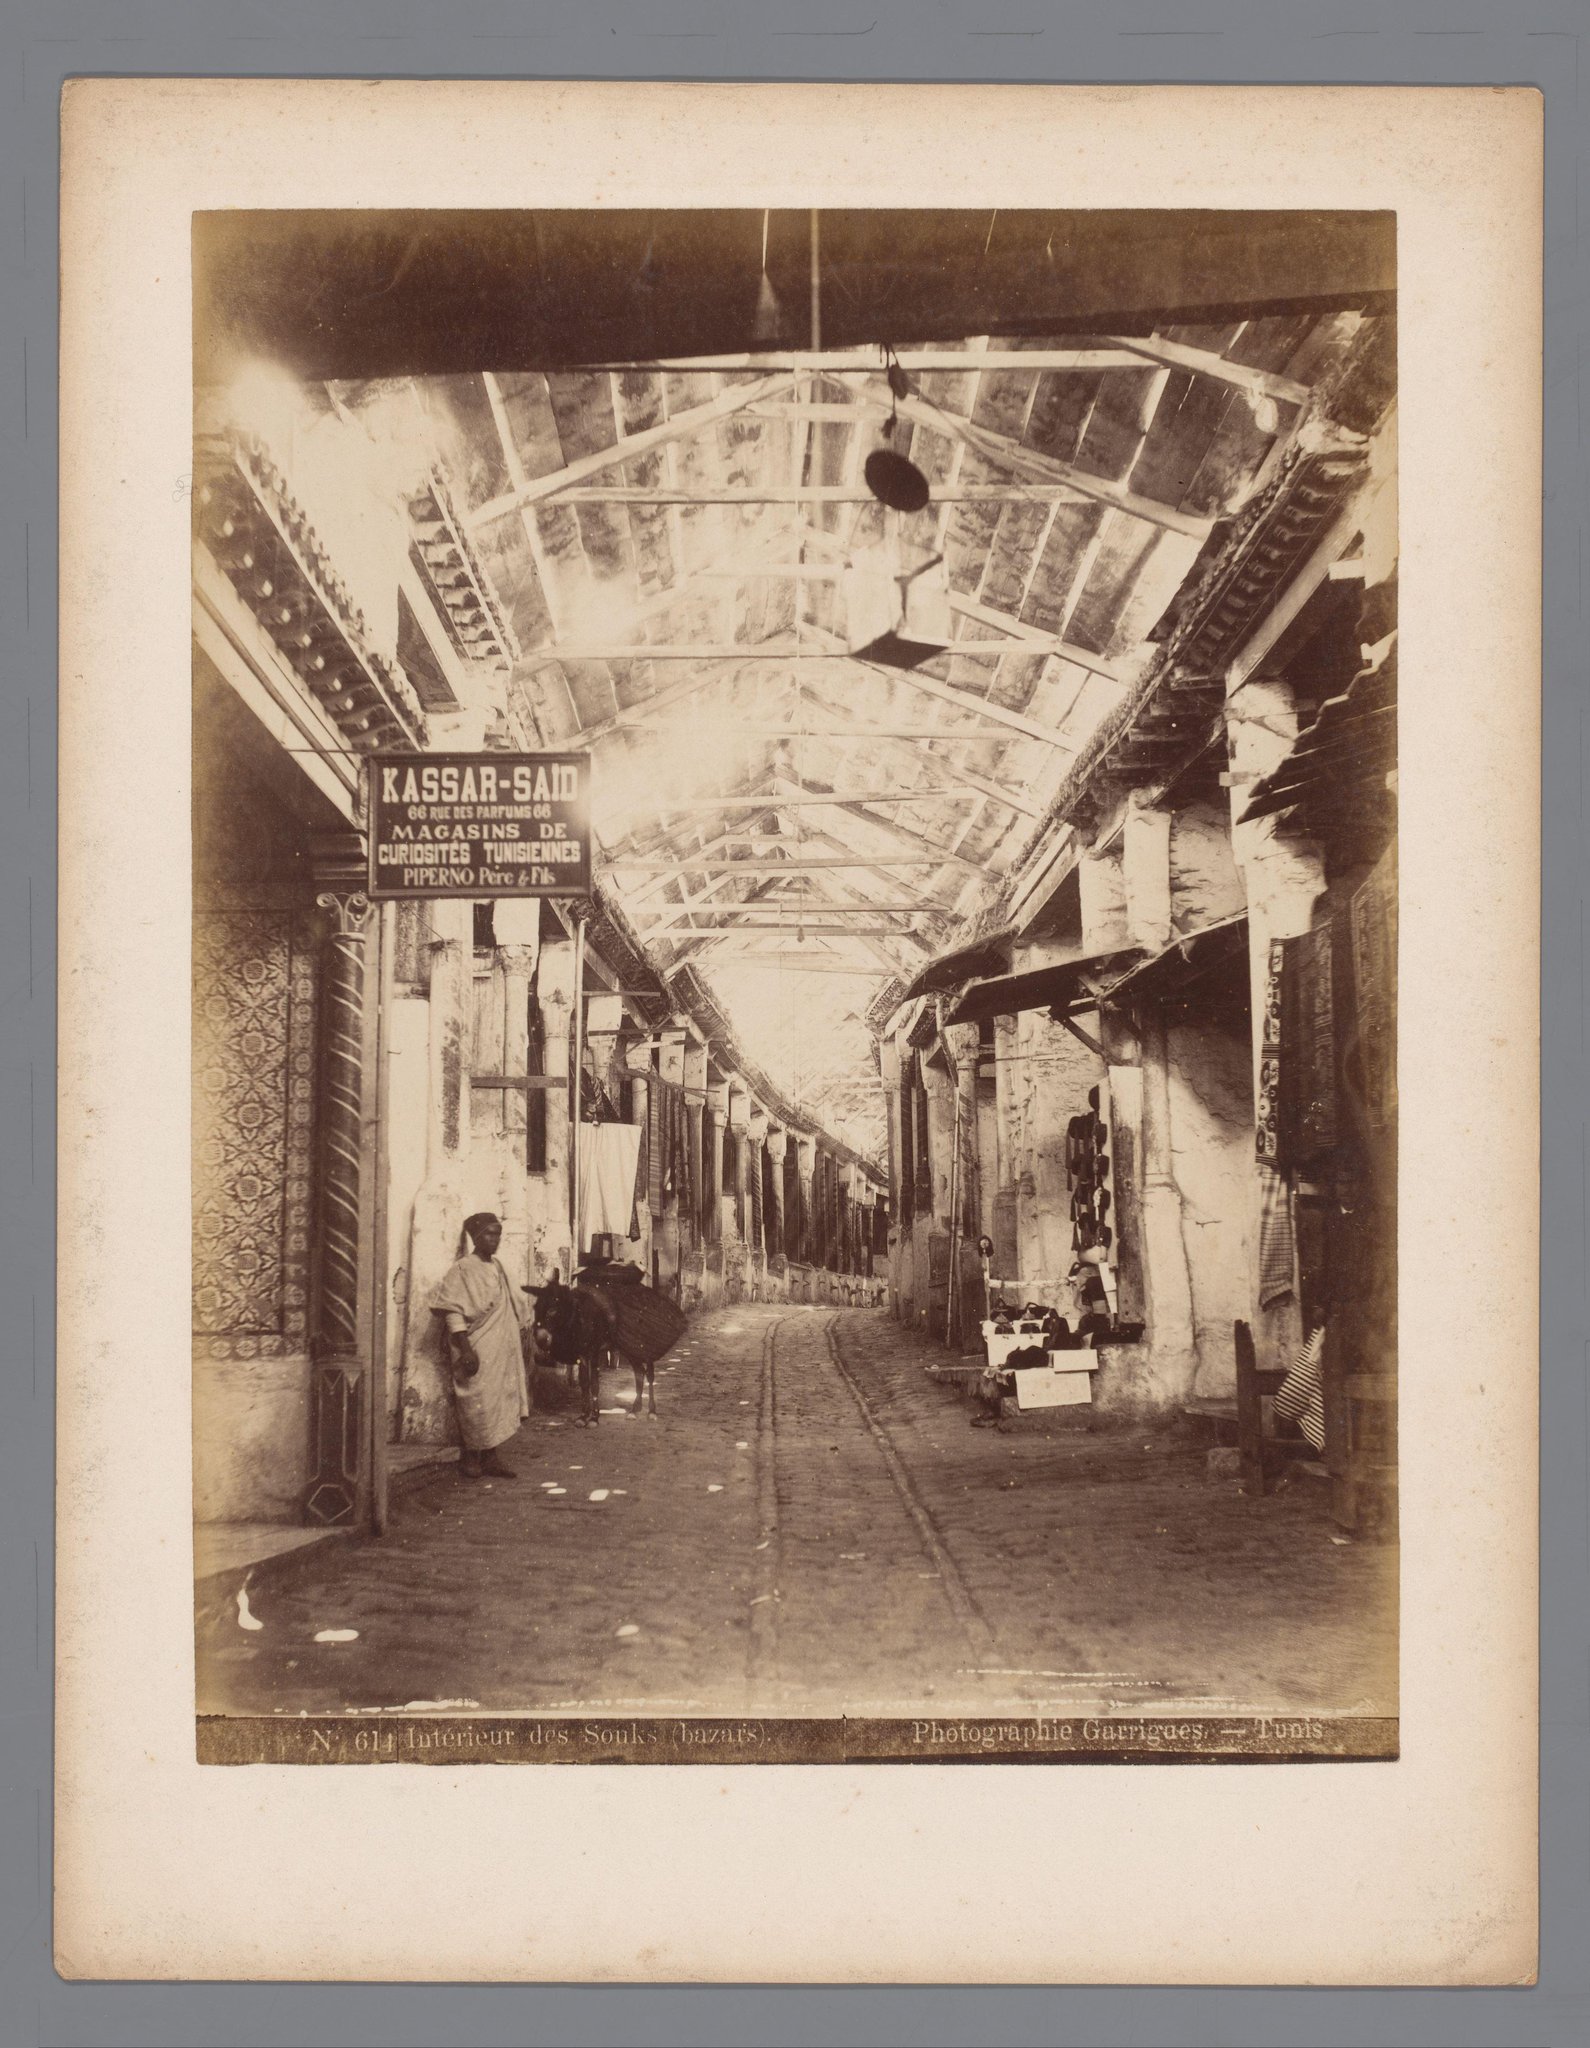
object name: photograph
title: Intérieur des Souks (bazars)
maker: j. andré garrigues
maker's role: fotograaf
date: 1860-1900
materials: cardboard, paper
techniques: albumen print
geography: tunis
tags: market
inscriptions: number: ‘N. 614’